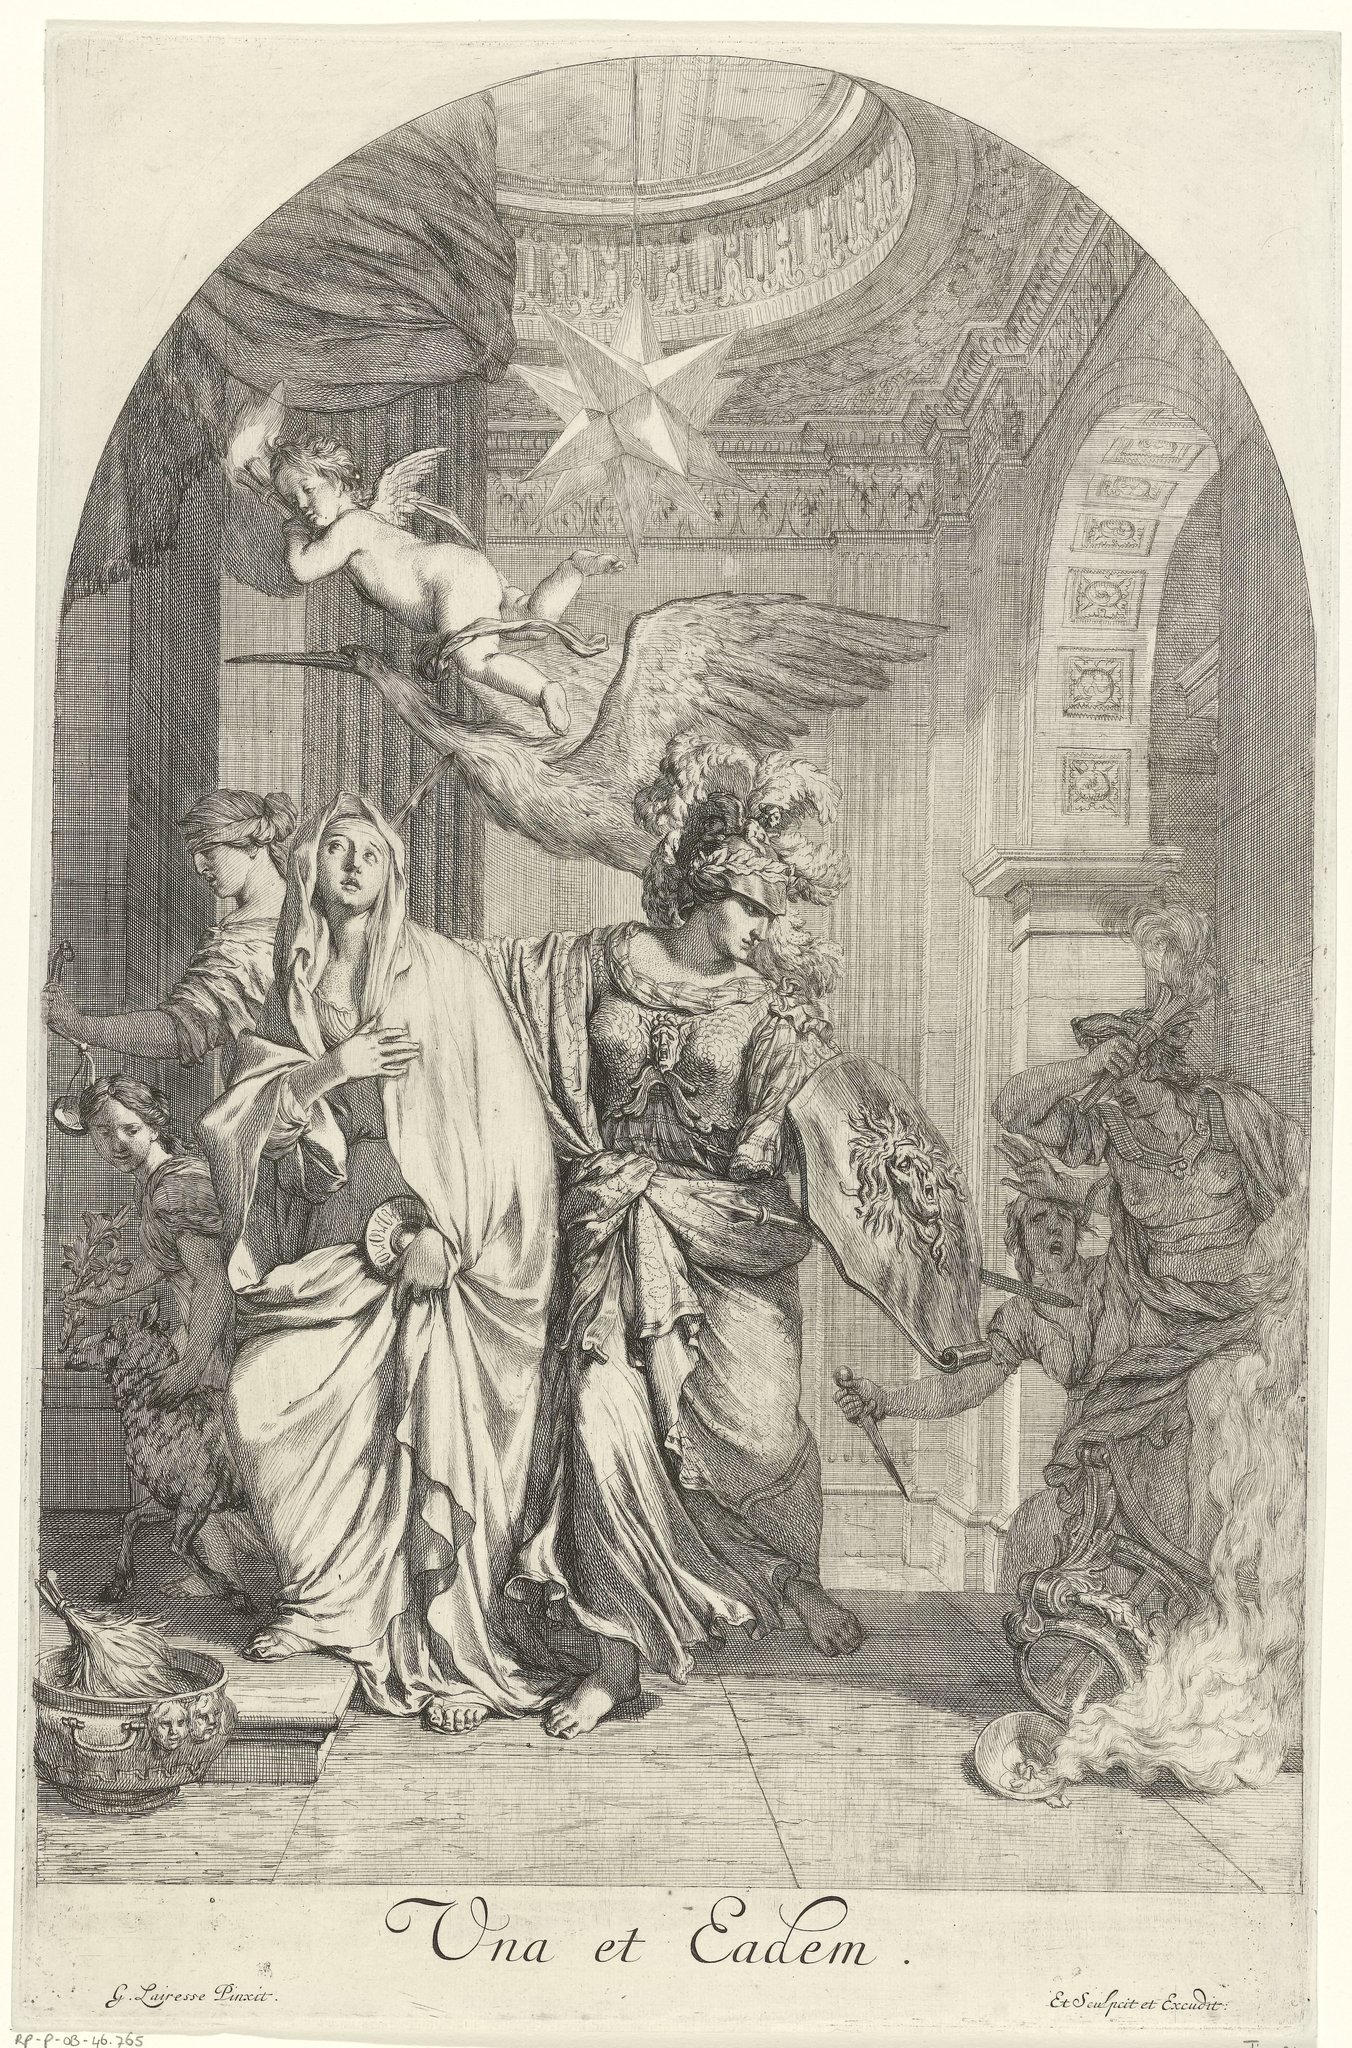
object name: print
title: Minerva beschermt drie Deugden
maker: gerard de lairesse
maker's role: draughtsman, painter, print maker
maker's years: 1641-1711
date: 1668-1670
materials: paper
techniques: etching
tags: shore-birds and wading-birds: crane, justice, 'justitia'; 'giustitia divina' (ripa) ~ one of the four cardinal virtues, (story of) minerva (pallas, athena), innocence; 'innocenza', 'innocenza o purità' (ripa), piety, 'pietas', 'timor dei' ~ the three theological virtues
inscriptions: collector's mark: Lugt 240